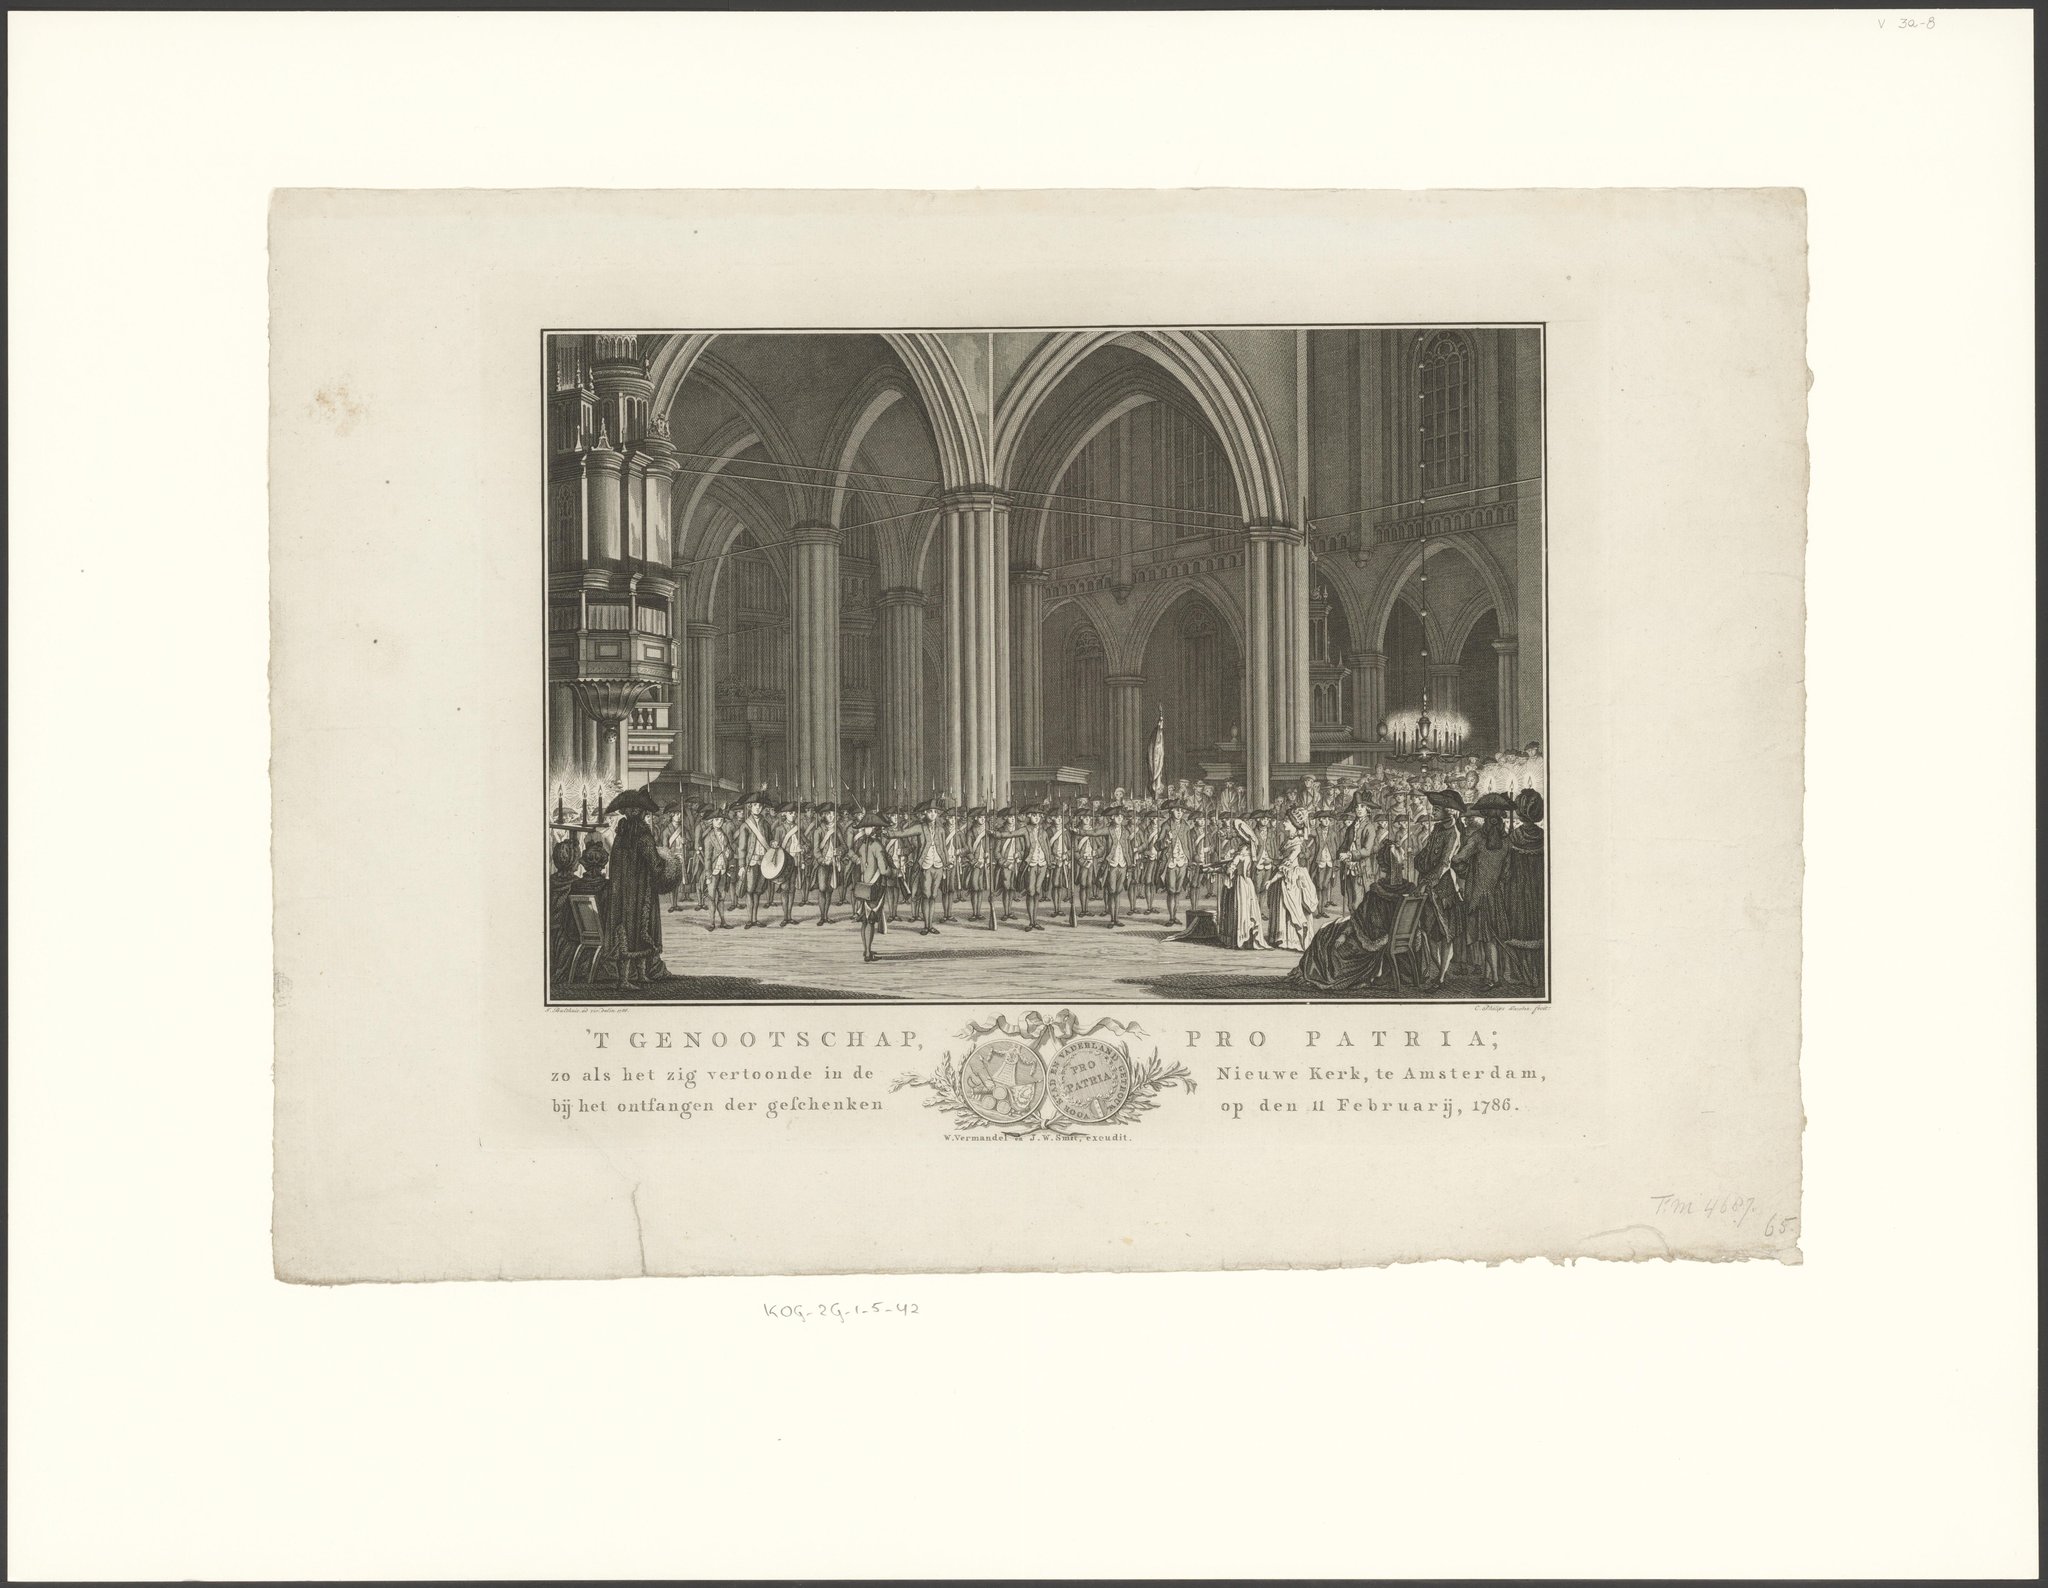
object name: print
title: 'T genootschap, pro patria; zo als het zig vertoonde in de Nieuwe Kerk, te Amsterdam, bij het ontfangen der geschenken op den 11 Februarij, 1786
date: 1786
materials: paper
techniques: engraving, etching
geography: amsterdam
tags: warfare; military affairs, the soldier; the soldier's life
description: Bijeenkomst van het Genootschap ter Oefening van de Wapenhandel Pro Patria in de Nieuwe Kerk te Amsterdam op 11 februari 1786, waar geschenken, overhandigd door een vrouw, in ontvangst worden genomen. In de marge voor- en achterzijde van een medaille van het genootschap. Onderwerpsrubrieken binnen de Atlas Zeden en Gewoonten: Krijgswezen, Schutterij, Historieprenten.